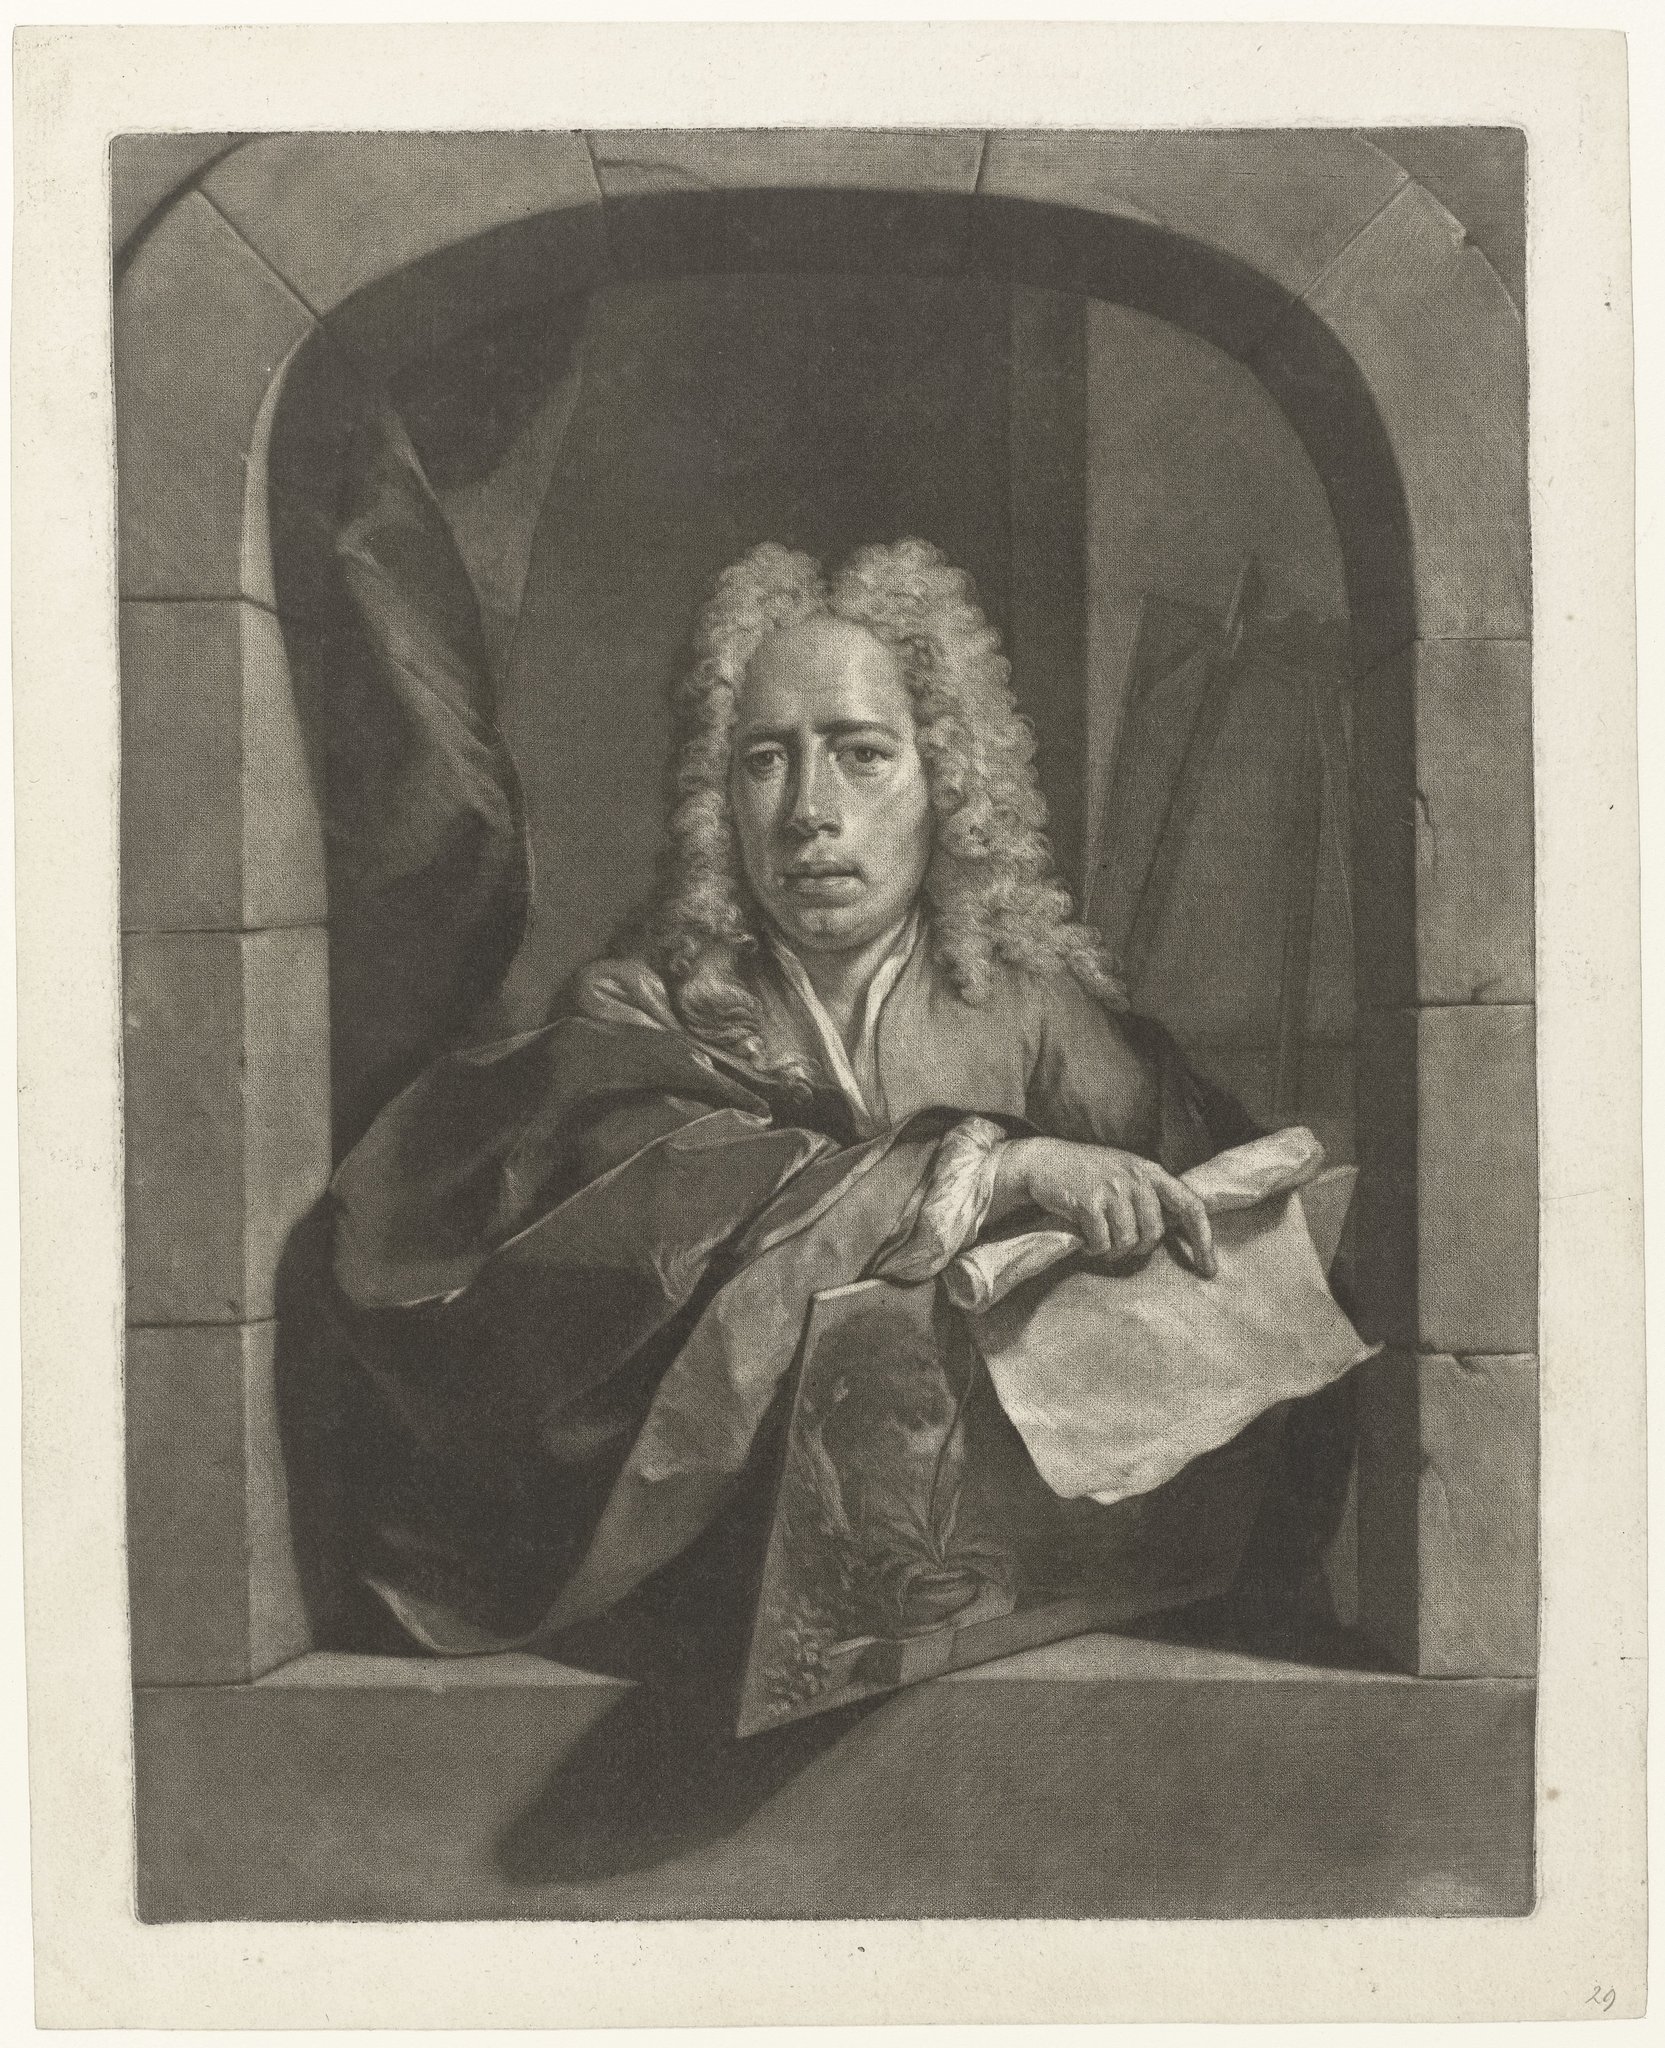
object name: print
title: Portret van Carel Borchaert Voet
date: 1700-1746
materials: paper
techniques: mezzotint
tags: dordrecht, draughtsman, carel borchaert voet, drawing, portrait, self-portrait of painter, easel, picture, painting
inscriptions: collector's mark: Lugt 240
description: De stillevenschilder Carel Borchaert Voet staat in een venster. In zijn hand heeft hij een paneel, waarop diverse planten, en een rol papier. Op de achtergrond en schildersezel.